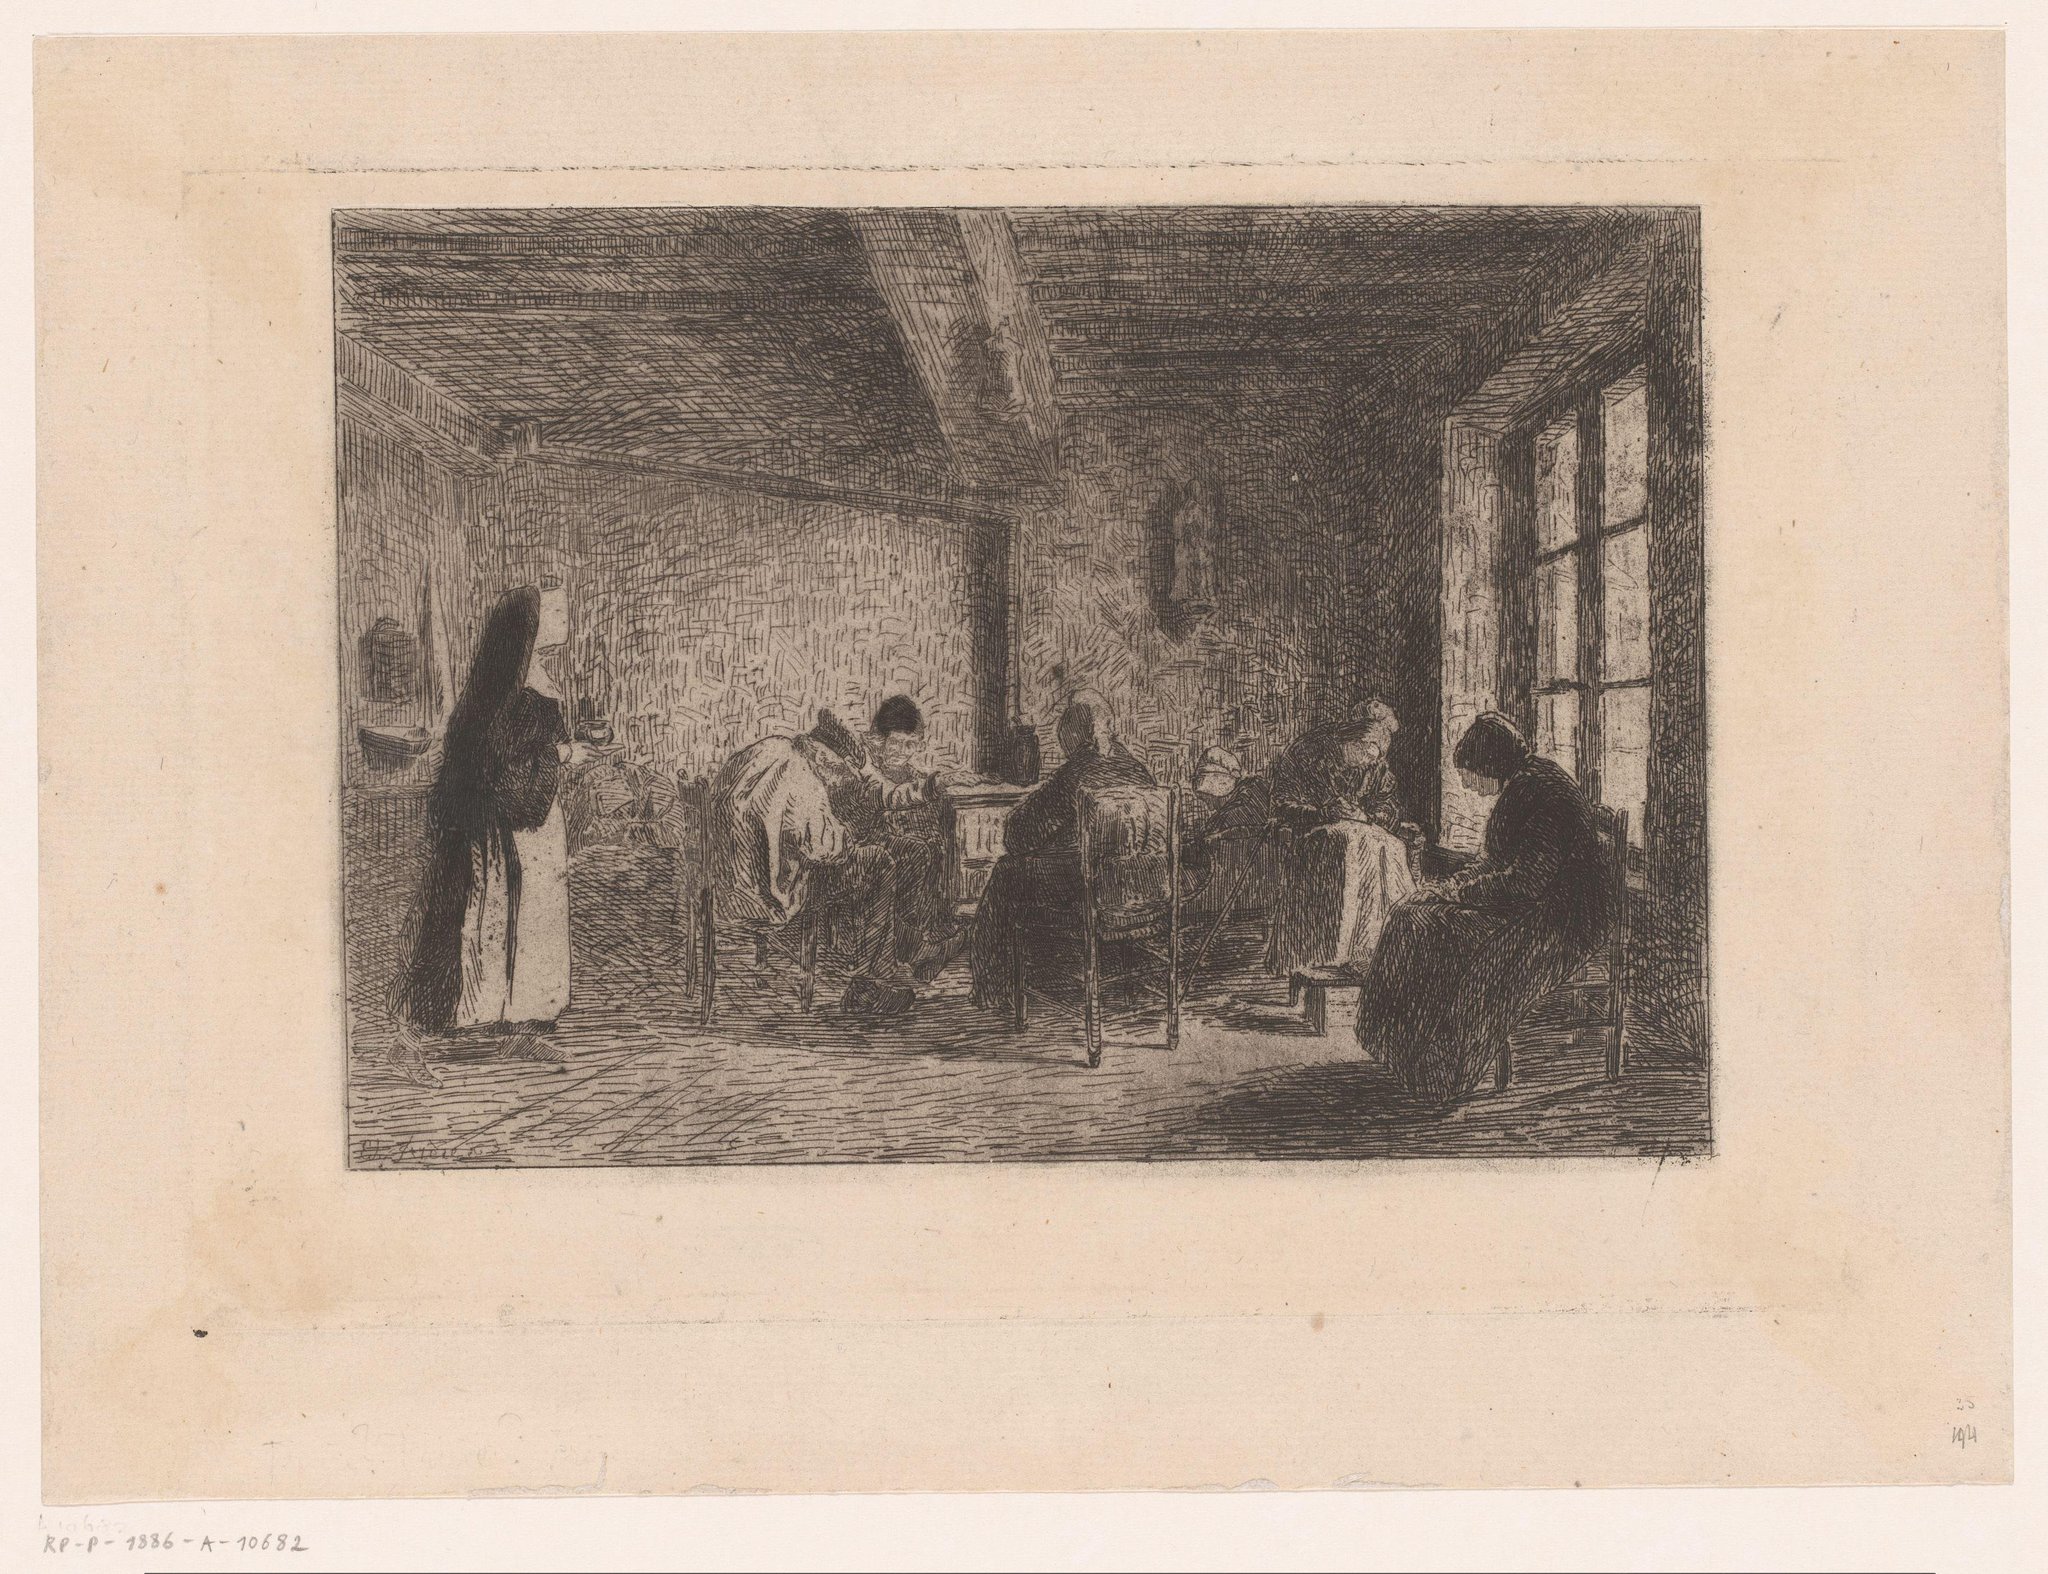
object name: print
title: Kamer met oude mensen, onder toezicht van een non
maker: pierre edouard frère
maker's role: print maker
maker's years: 1819-1886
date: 1863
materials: paper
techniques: aquatint, drypoint, etching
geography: france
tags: nun(s), old-people's home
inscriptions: collector's mark: Lugt 2228